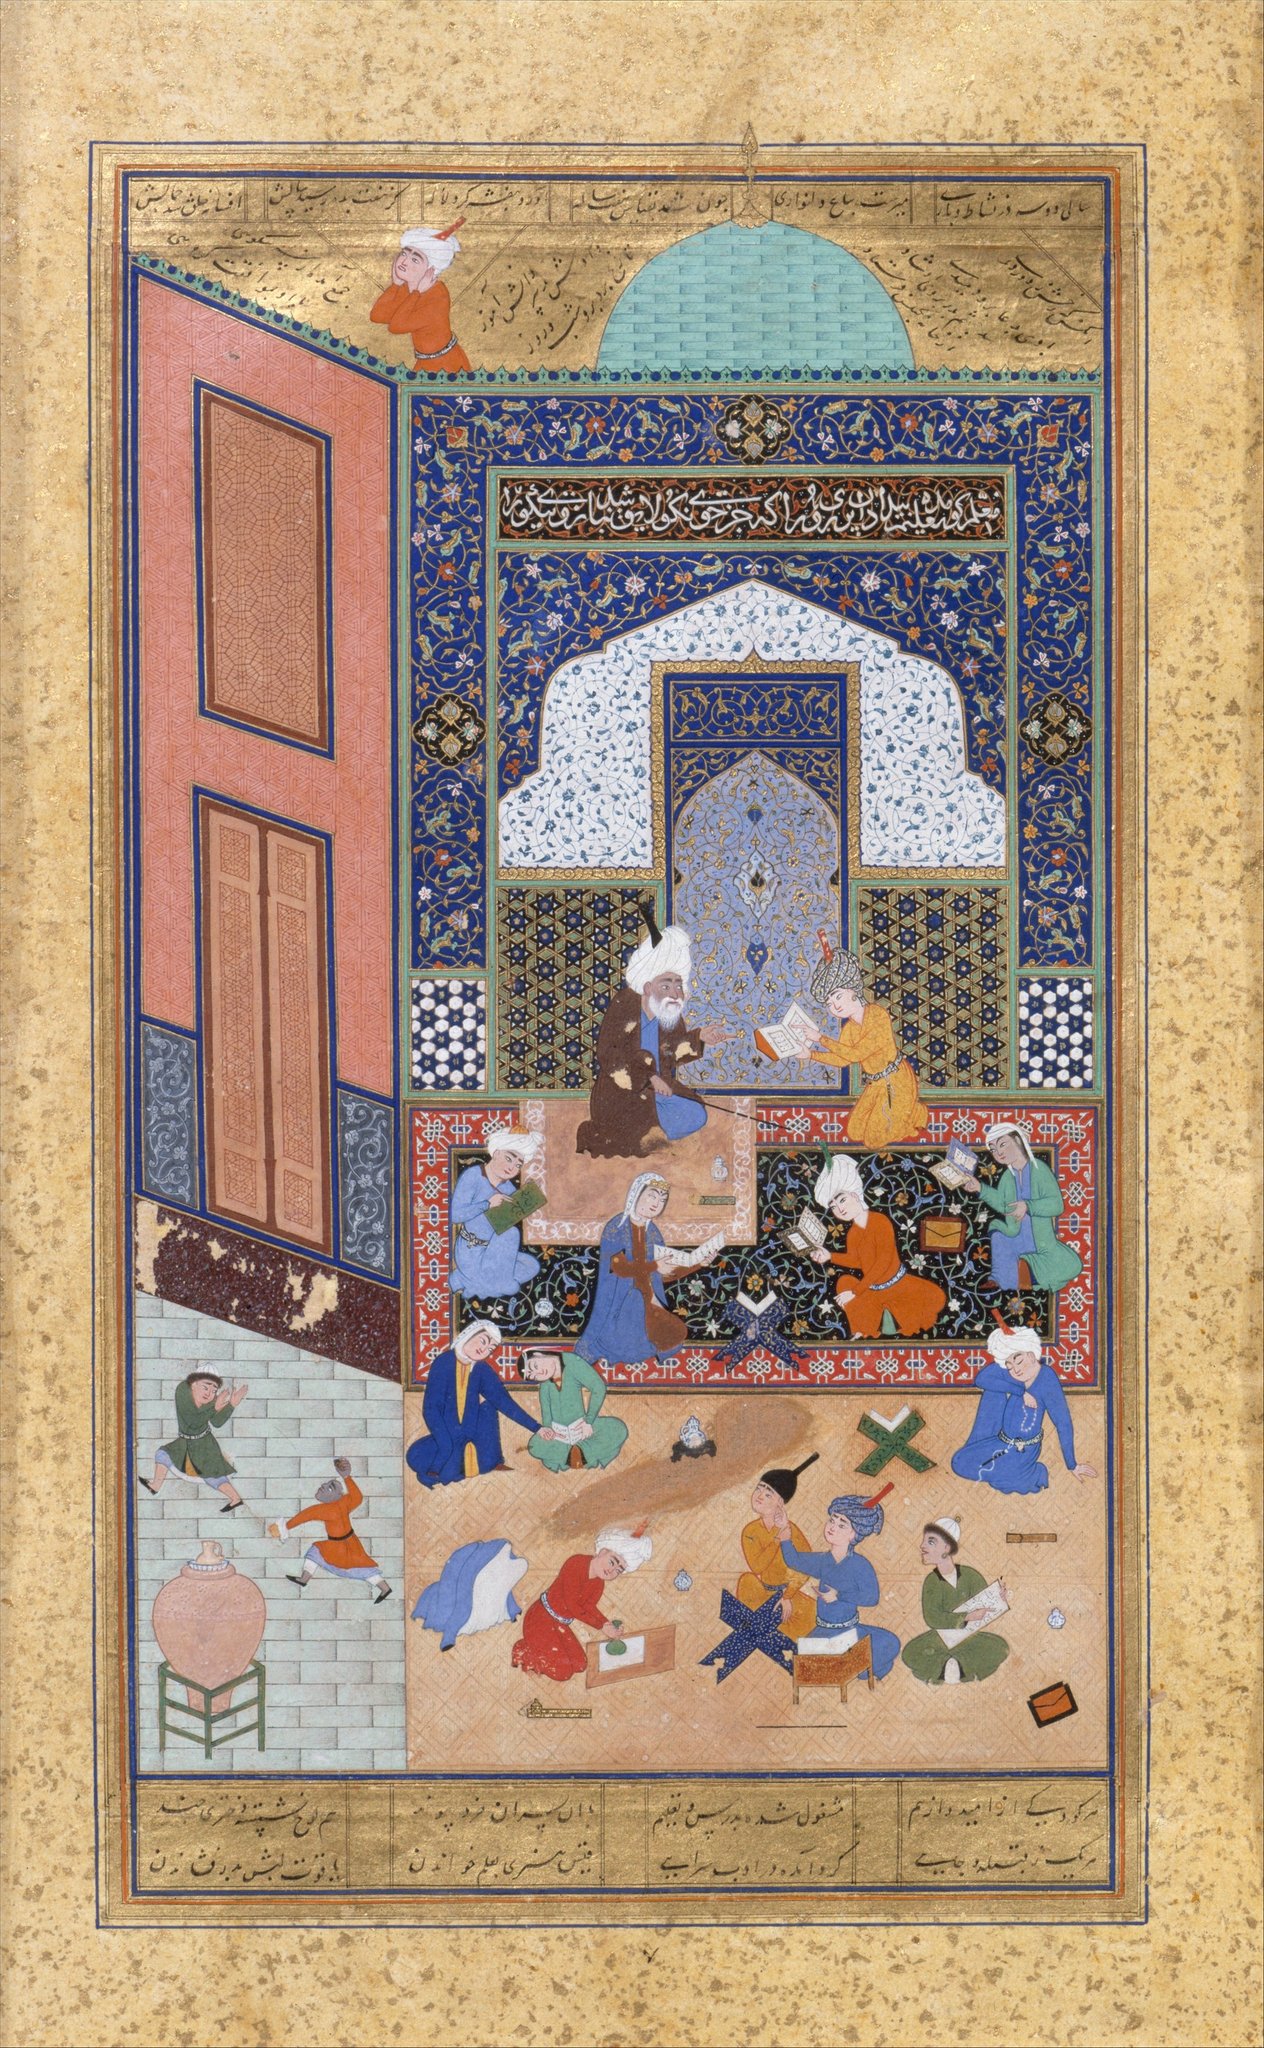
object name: folio from an illustrated manuscript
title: "Laila and Majnun in School", Folio 129 from a Khamsa (Quintet) of Nizami of Ganja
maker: nizami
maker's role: author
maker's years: 1141-1209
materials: gold, ink, paper, watercolor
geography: afghanistan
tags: books,schools,children,reading,students,teachers